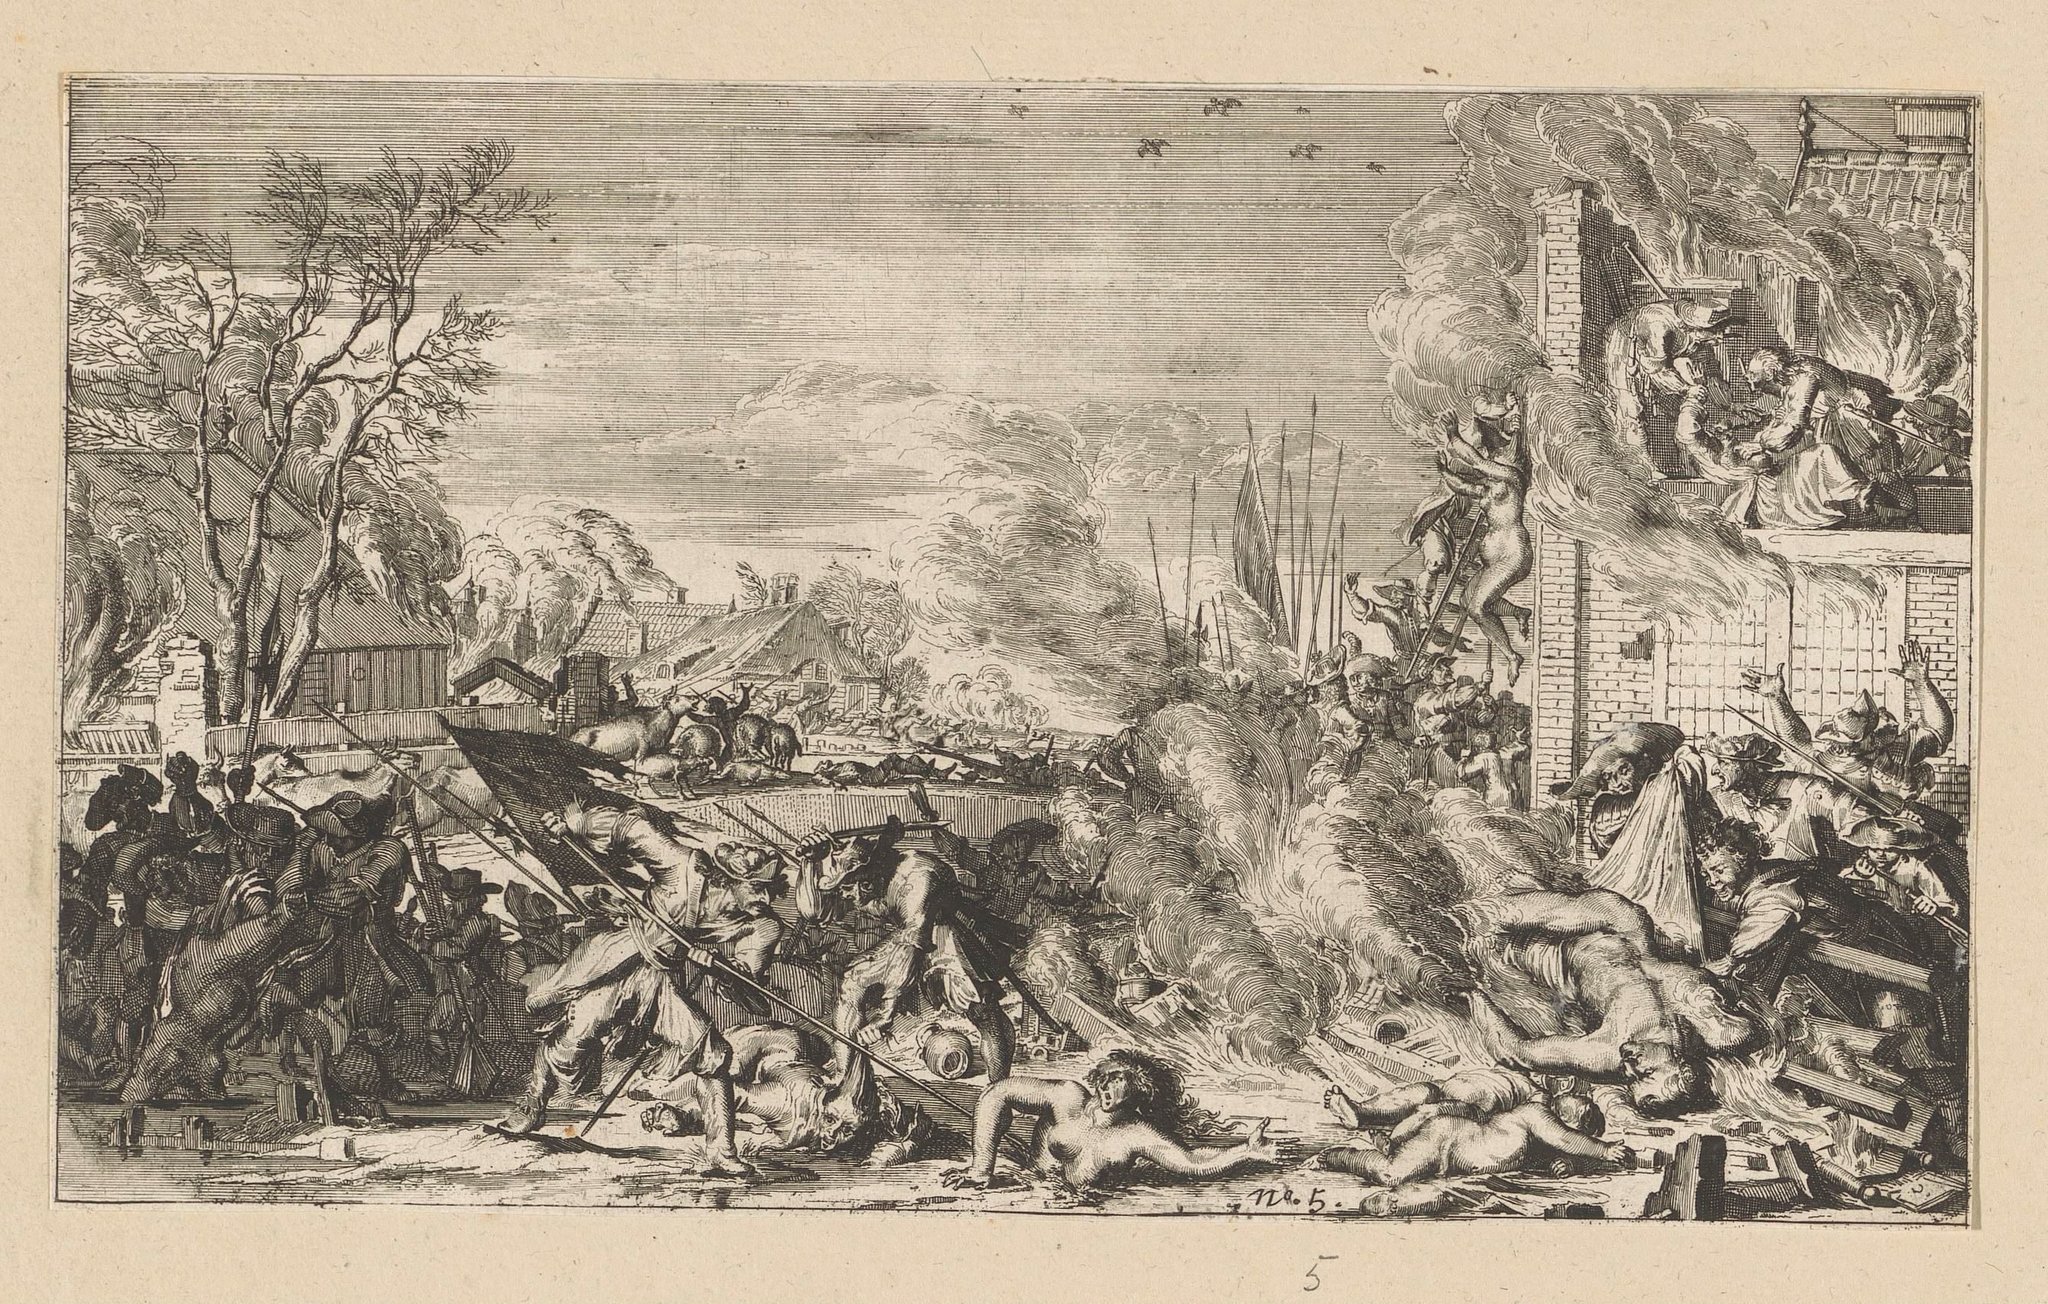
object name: print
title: Wreedheden in een dorp in de winter, 1672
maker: Anonymous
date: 1673-1677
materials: paper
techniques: engraving, etching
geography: northern netherlands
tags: rape, violation, violent death, being killed; being mishandled and maltreated; seeking death, massacre ~ war, bodegraven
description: Prent ook gebruikt in: Bosch, Lambert van den. Toneel des oorlogs, opgerecht in de Vereenigde Nederlanden; door de wapenen van de koningen van Vrankrijk en Engeland, Keulsche en Munstersche (…). 4 delen. Amsterdam: Jacob van Meurs en Johannes van Someren, 1675, dl. 3, p. 120. En in: Valckenier, Peter en Andreas Muller. Das verwirrte Europa (…). 3 delen. Amsterdam: Hendrik en Dirk Boom, Joannes van Someren en Jacob van Meurs, 1677-1683, dl. 1 (1677), p. 194. Deze prent is gekopieerd naar een prent van Romeyn de Hooghe (RP-P-OB-77.197). Die prent is gebruikt in: Wicquefort, Abraham van. Avis fidelle aux veritables hollandois. Touchant ce qui s’est passé dans les villages de Bodegrave & Swammerdam, & les cruautés inoüies, que les françois y ont exercées (…). S.l. [Den Haag]: s.n.[Daniel en Johannes Steucker], 1673.